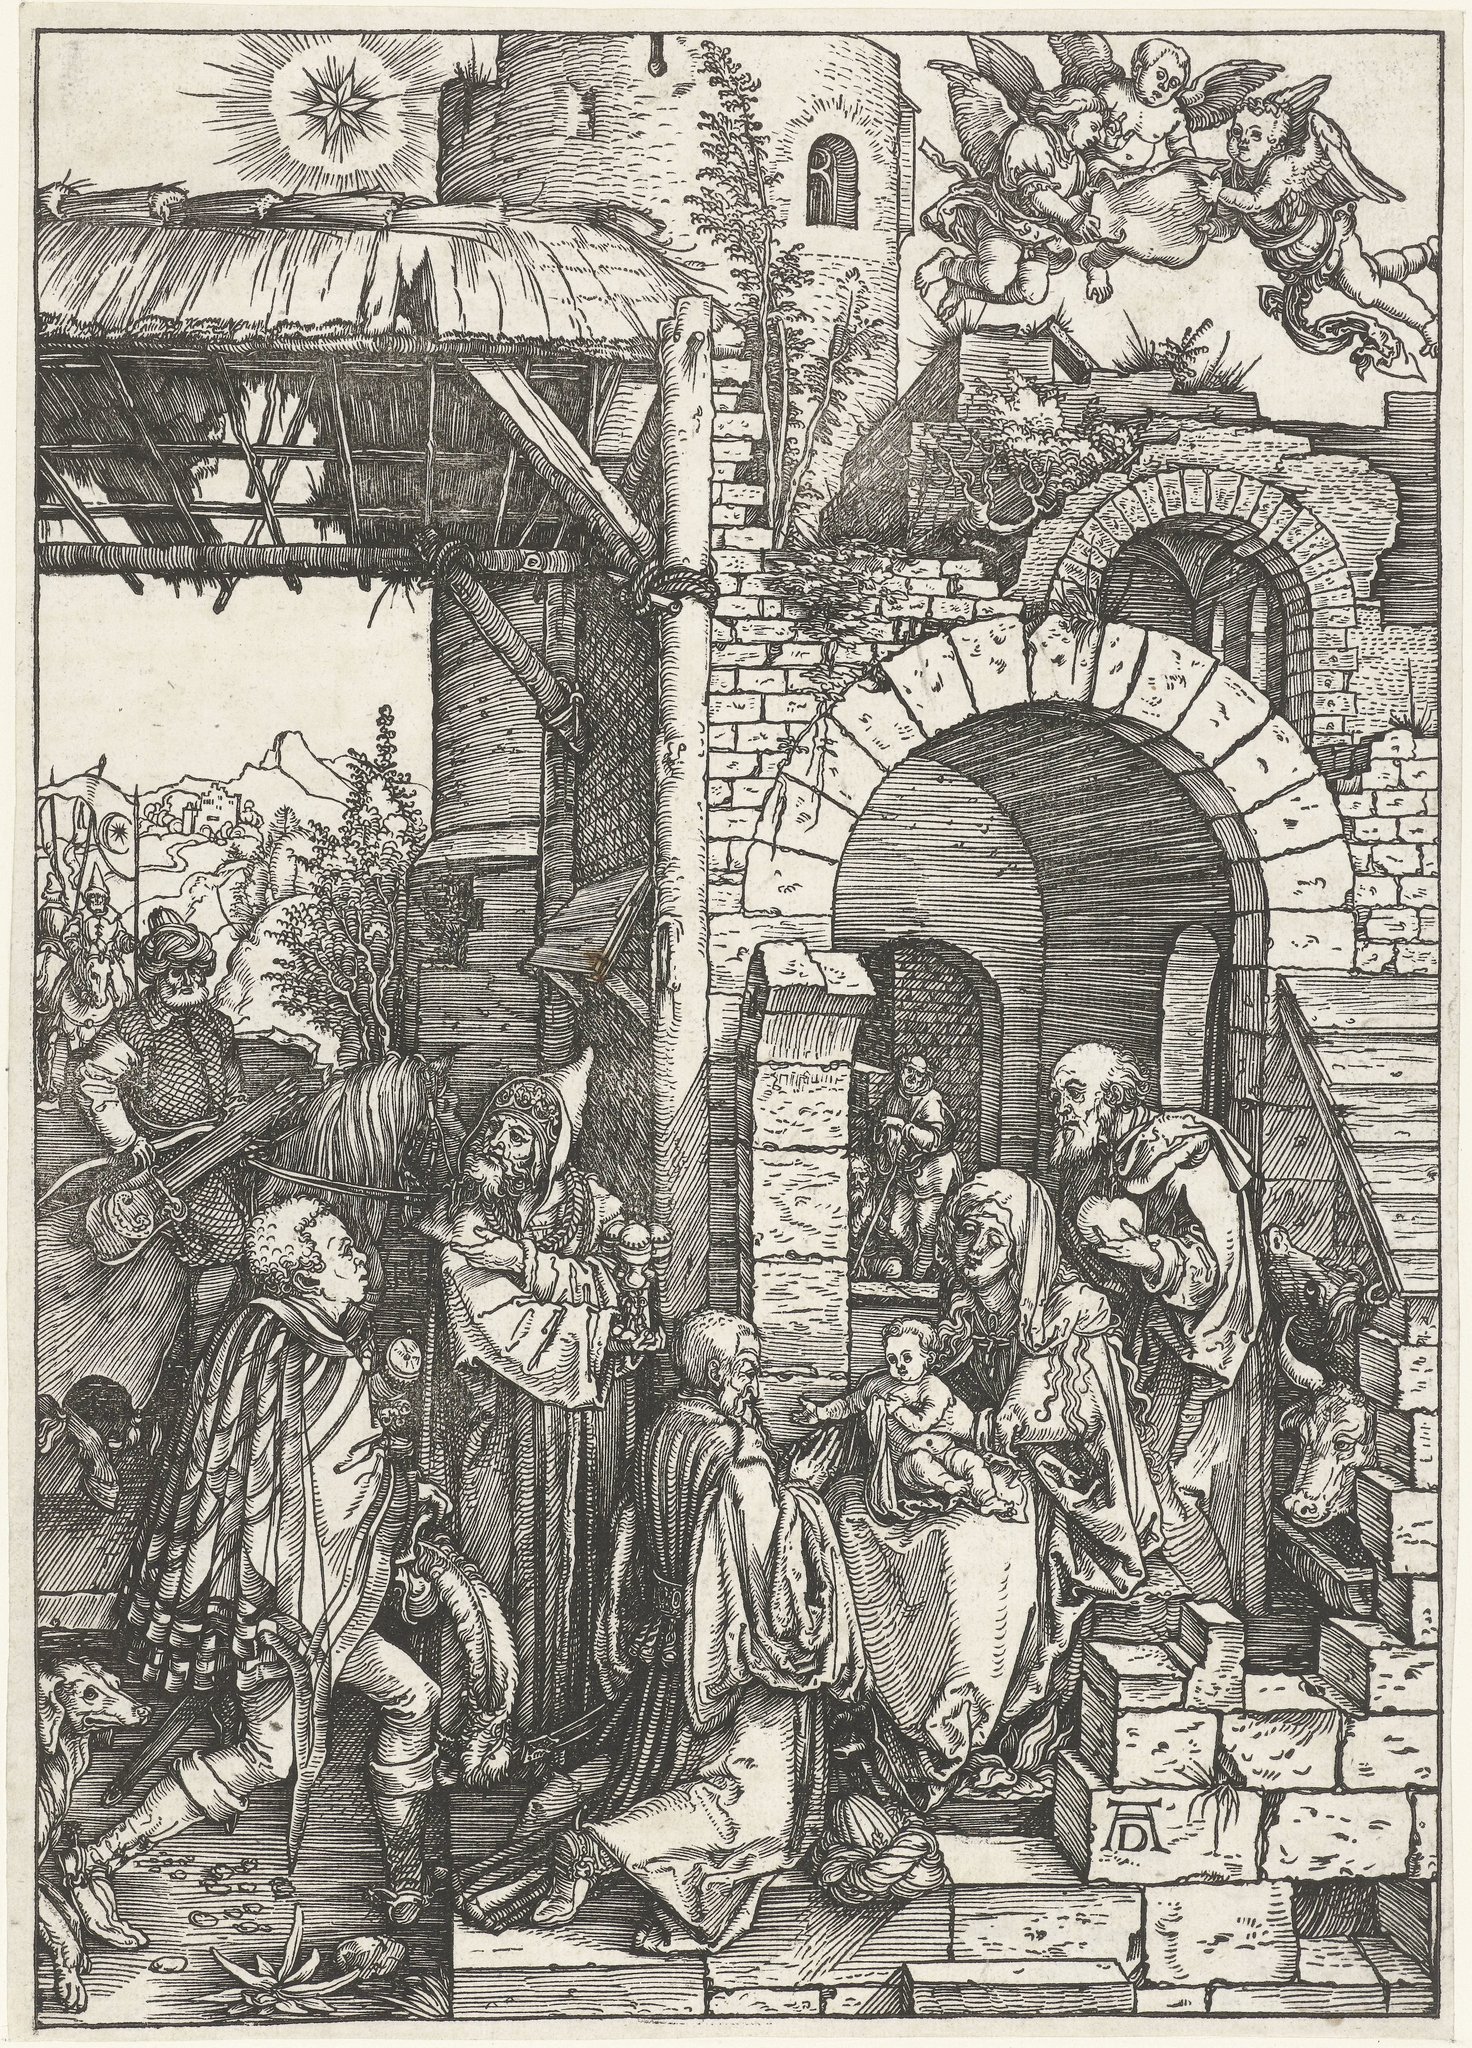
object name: print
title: Leven van Maria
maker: albrecht dürer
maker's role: draughtsman, painter, print maker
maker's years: 1471-1528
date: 1501-1505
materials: paper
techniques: woodcut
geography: nuremberg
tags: adoration of the kings: the wise men present their gifts to the christ-child (gold, frankincense and myrrh)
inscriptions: collector's mark: Lugt 240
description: Maria zit met het Christuskind op schoot bij de ingang van een vervallen gebouw. Achter haar staat Jozef. De drie koningen of wijzen uit het Oosten bieden Christus hun geschenken aan. Deze prent is onderdeel van een serie van 20 prenten, bestaand uit een titelprent en 19 prenten met scènes uit het leven van Maria.